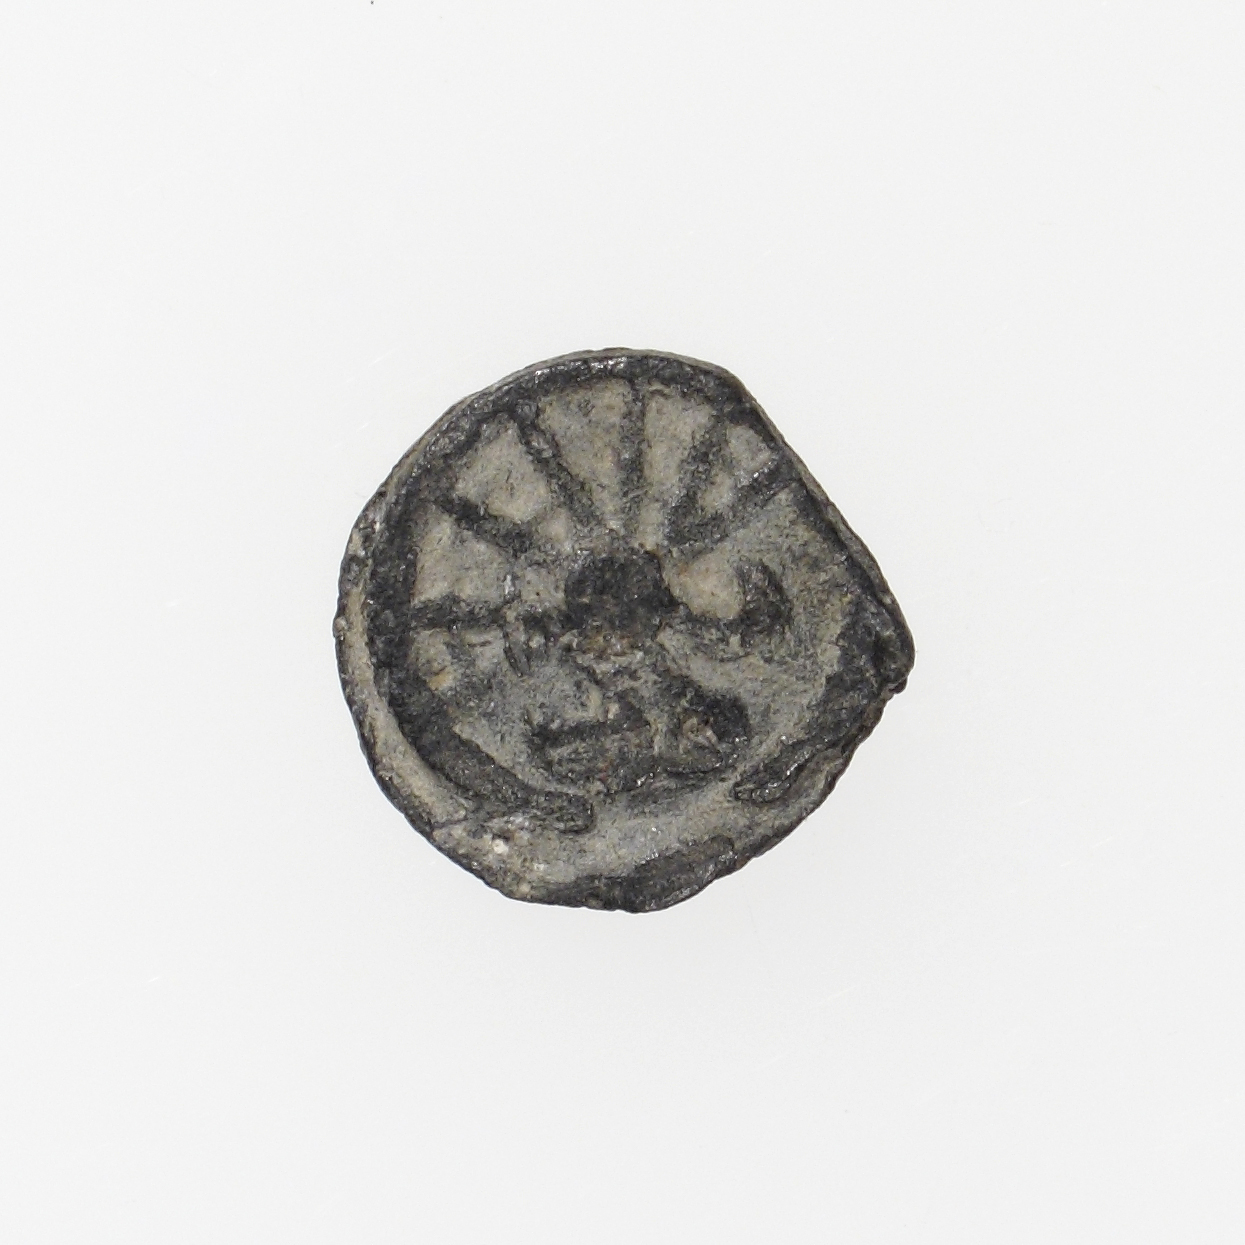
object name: pilgrim's badge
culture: french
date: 1301-1600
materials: lead